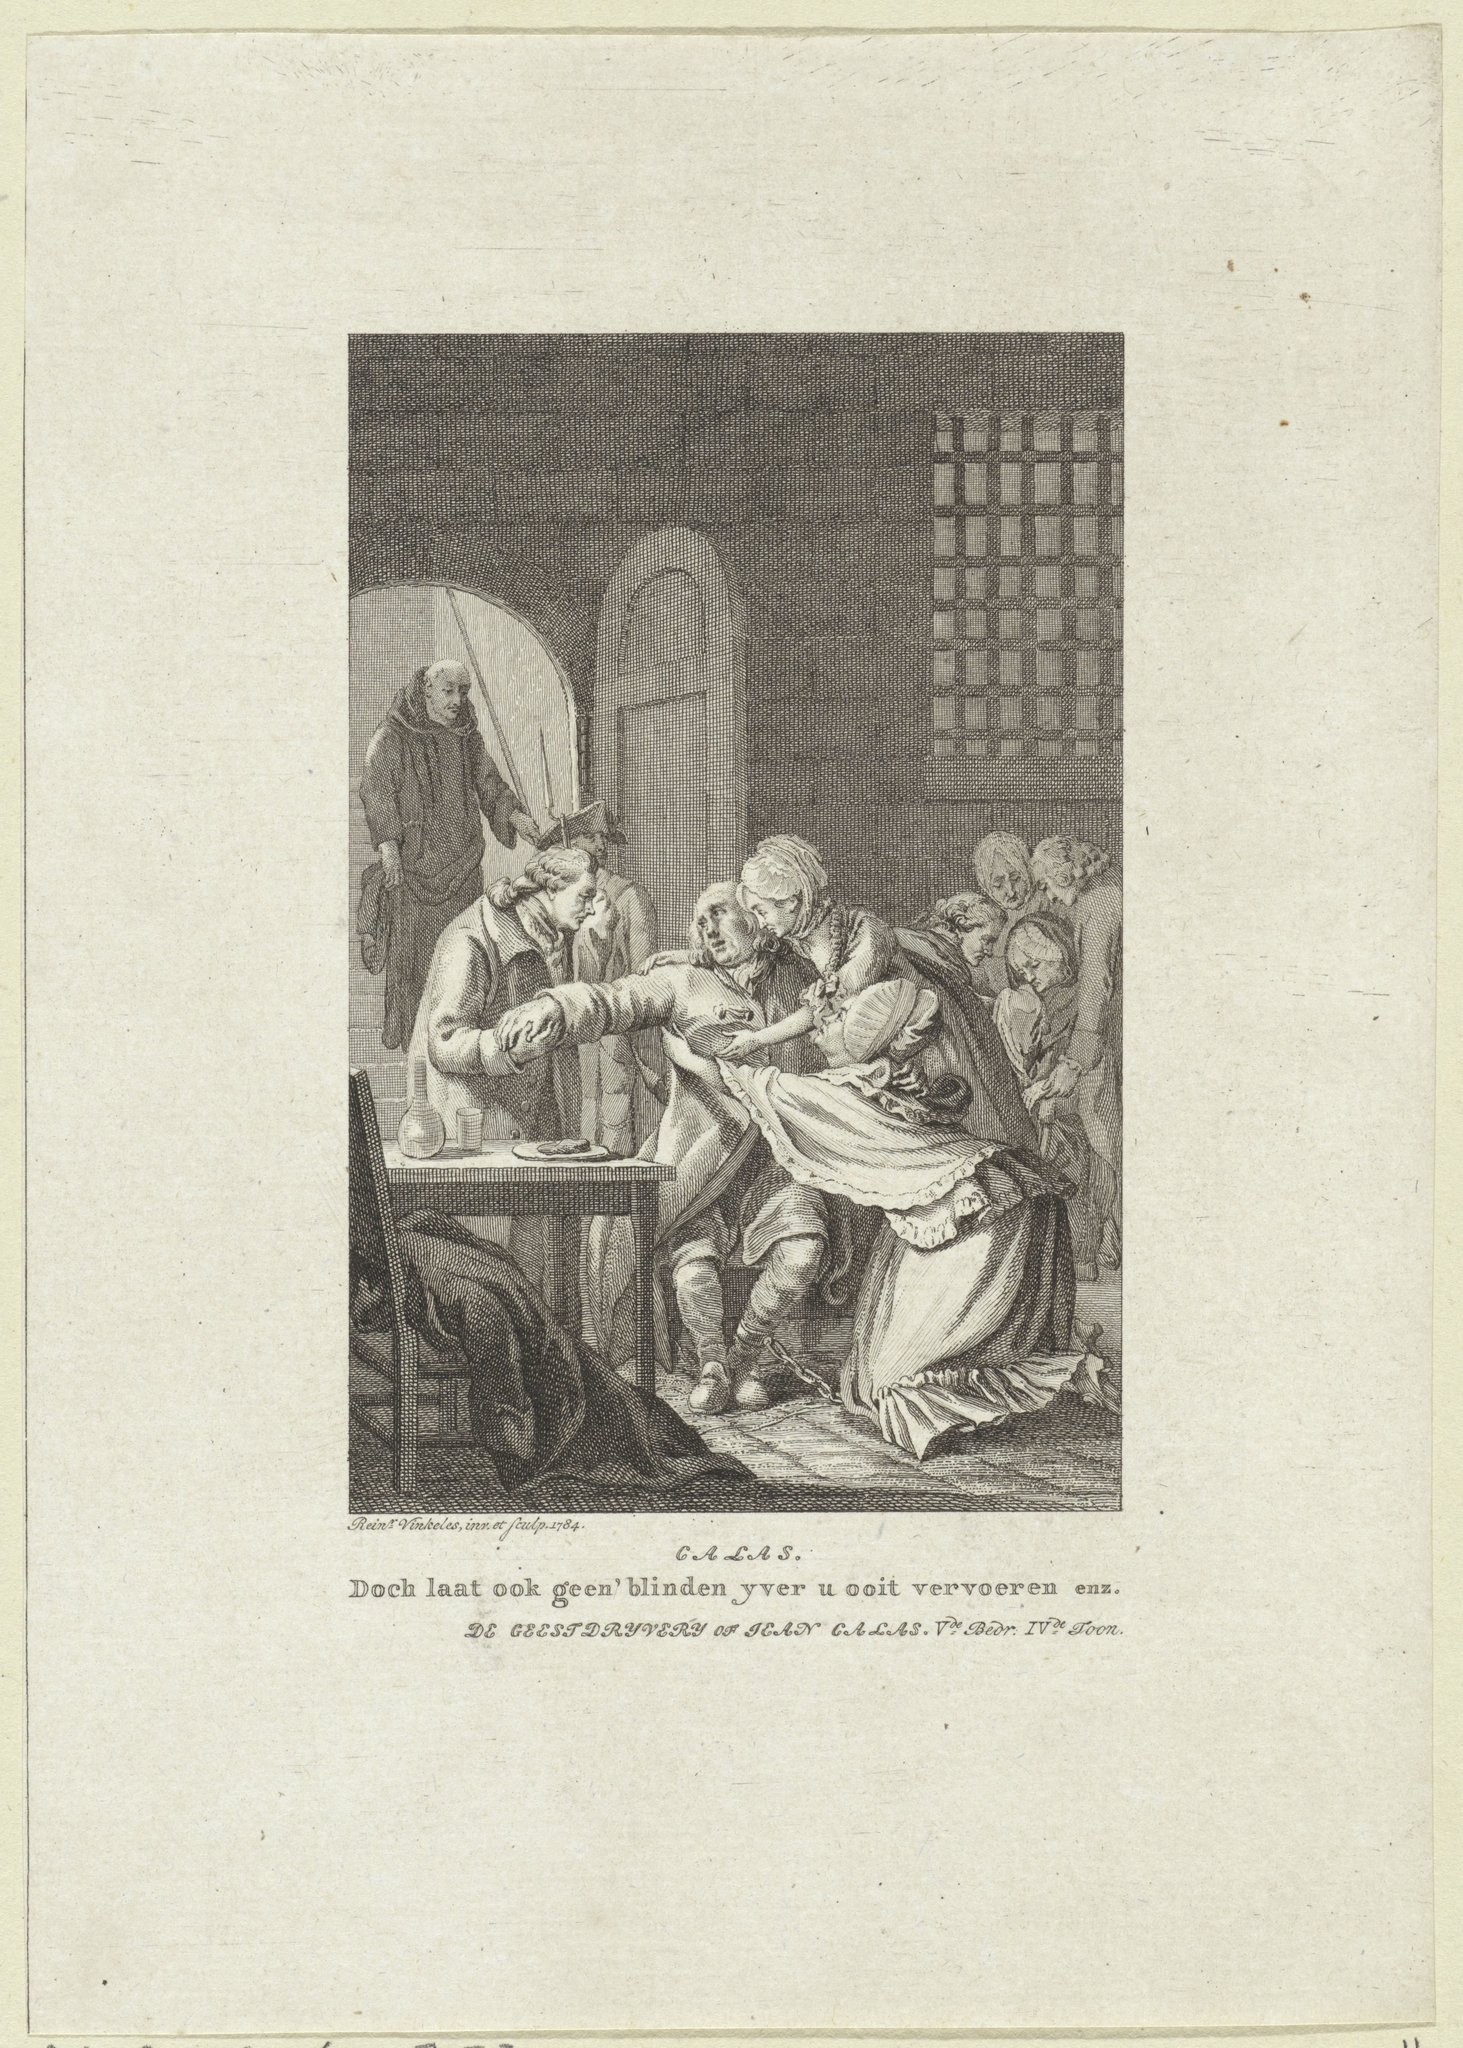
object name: print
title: Huilende en wanhopige figuren in een cel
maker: reinier vinkeles (i)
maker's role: draughtsman, print maker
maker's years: 1741-1816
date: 1784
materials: paper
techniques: engraving, etching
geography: amsterdam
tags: prison, jail, monk(s), friar(s), weeping, kneeling figure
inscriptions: collector's mark: Lugt 240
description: Deze prent is mogelijk gebruikt als illustratie in: Weisse, Christian Felix. De geestdryvery, of Jean Calas. Amsterdam: Pieter Meĳer, 1784.